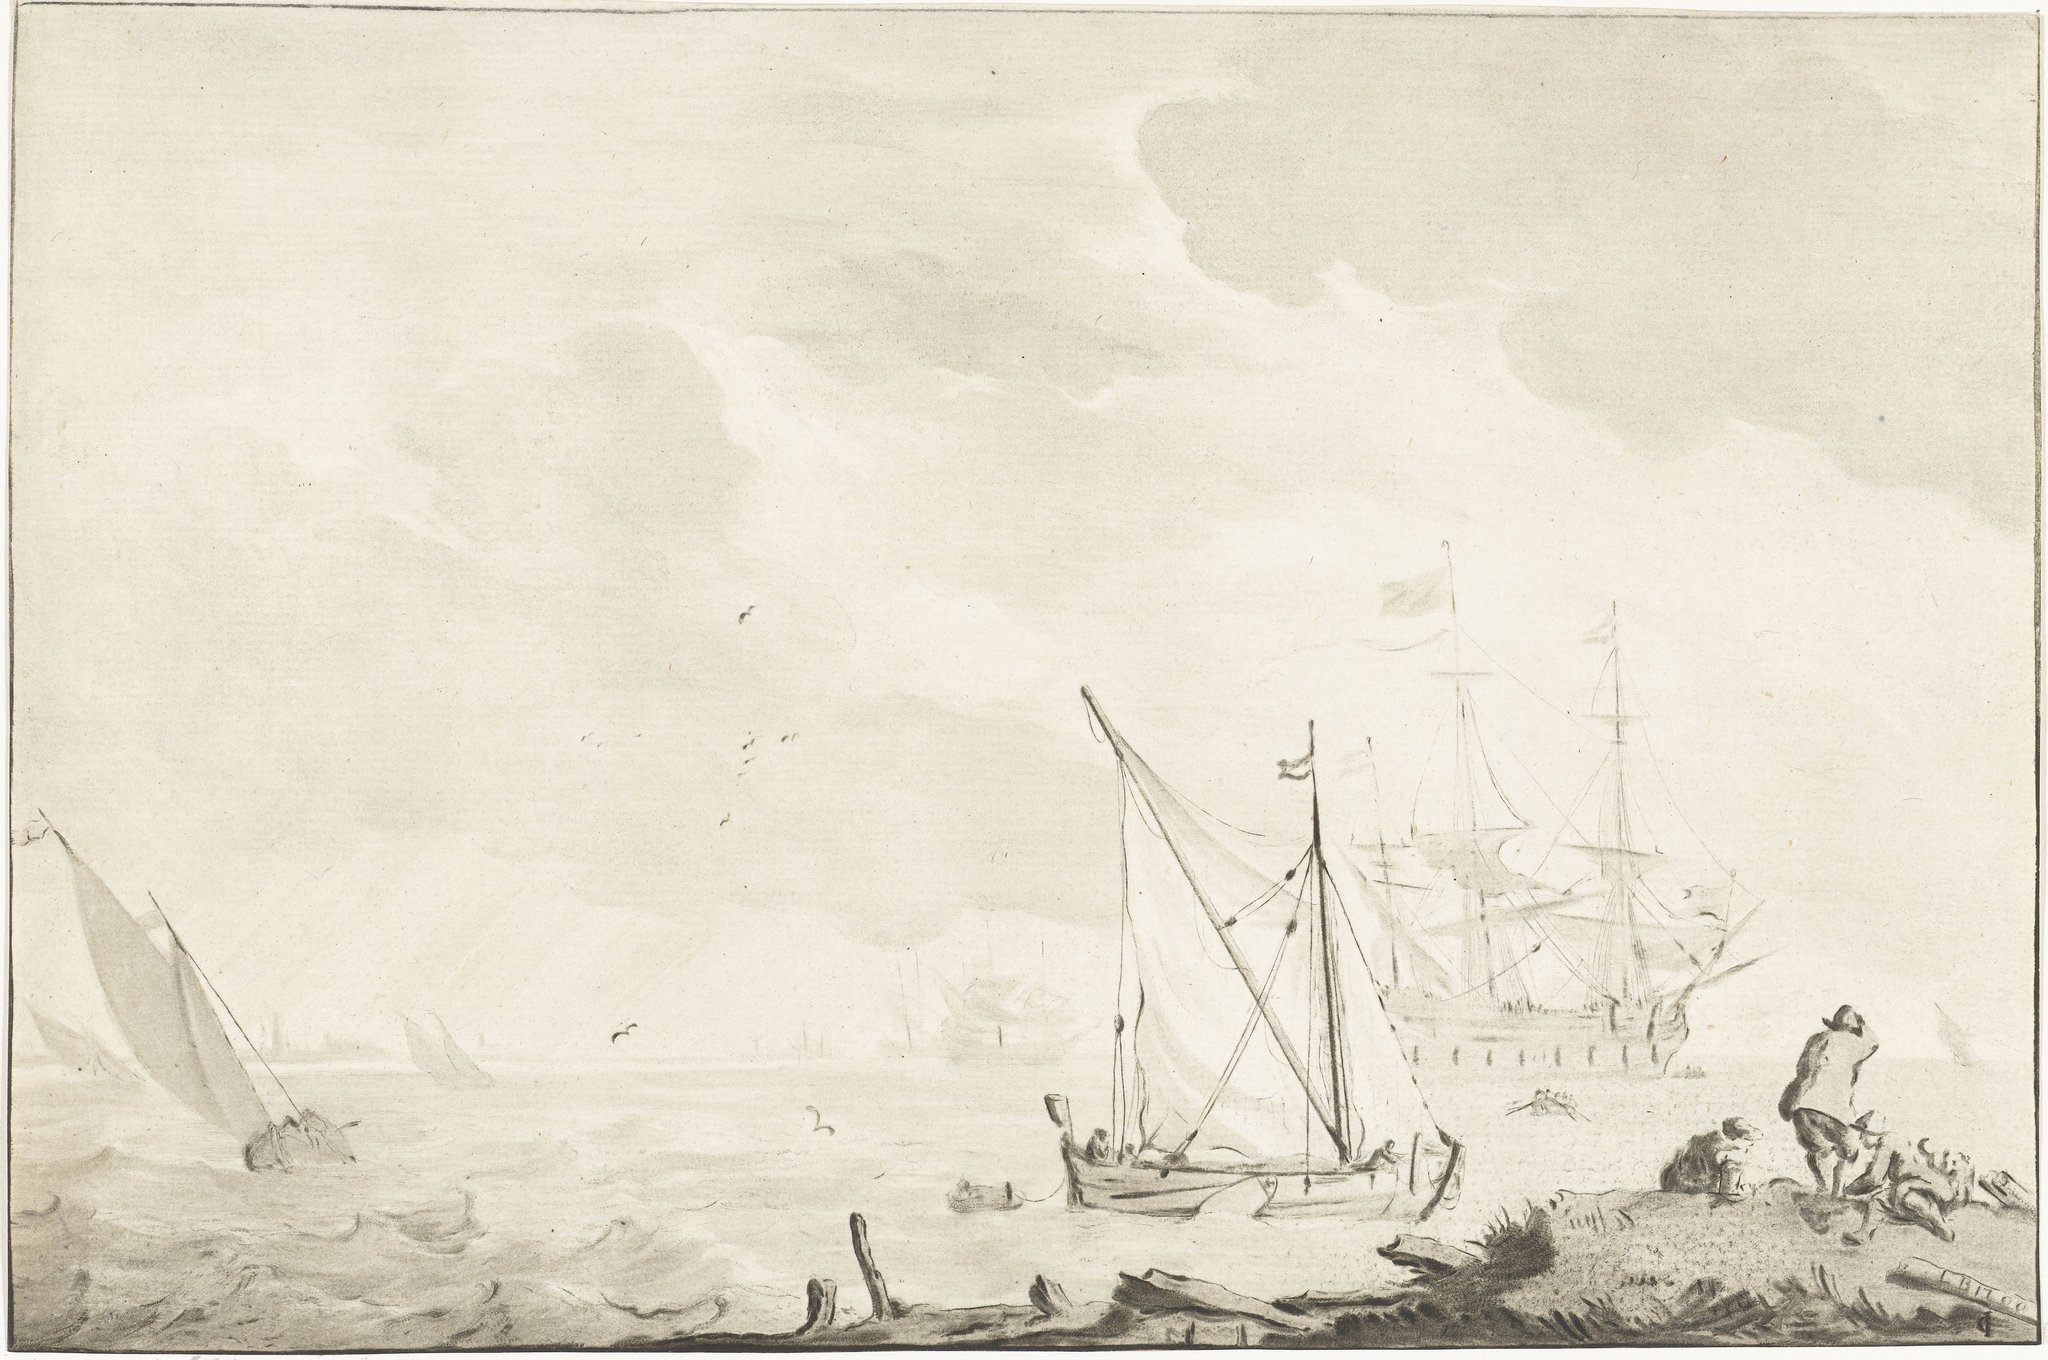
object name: print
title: Oorlogsschip bij het strand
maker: jurriaan cootwijck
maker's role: print maker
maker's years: 1714-1798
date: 1724-1798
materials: paper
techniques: print drawing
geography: amsterdam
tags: coast (+ landscape with figures, staffage)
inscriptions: collector's mark: Lugt 2228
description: Een woelige zee met verschillende schepen, ondermeer een galjoen. Op de voorgrond drie mannen op de duinen.